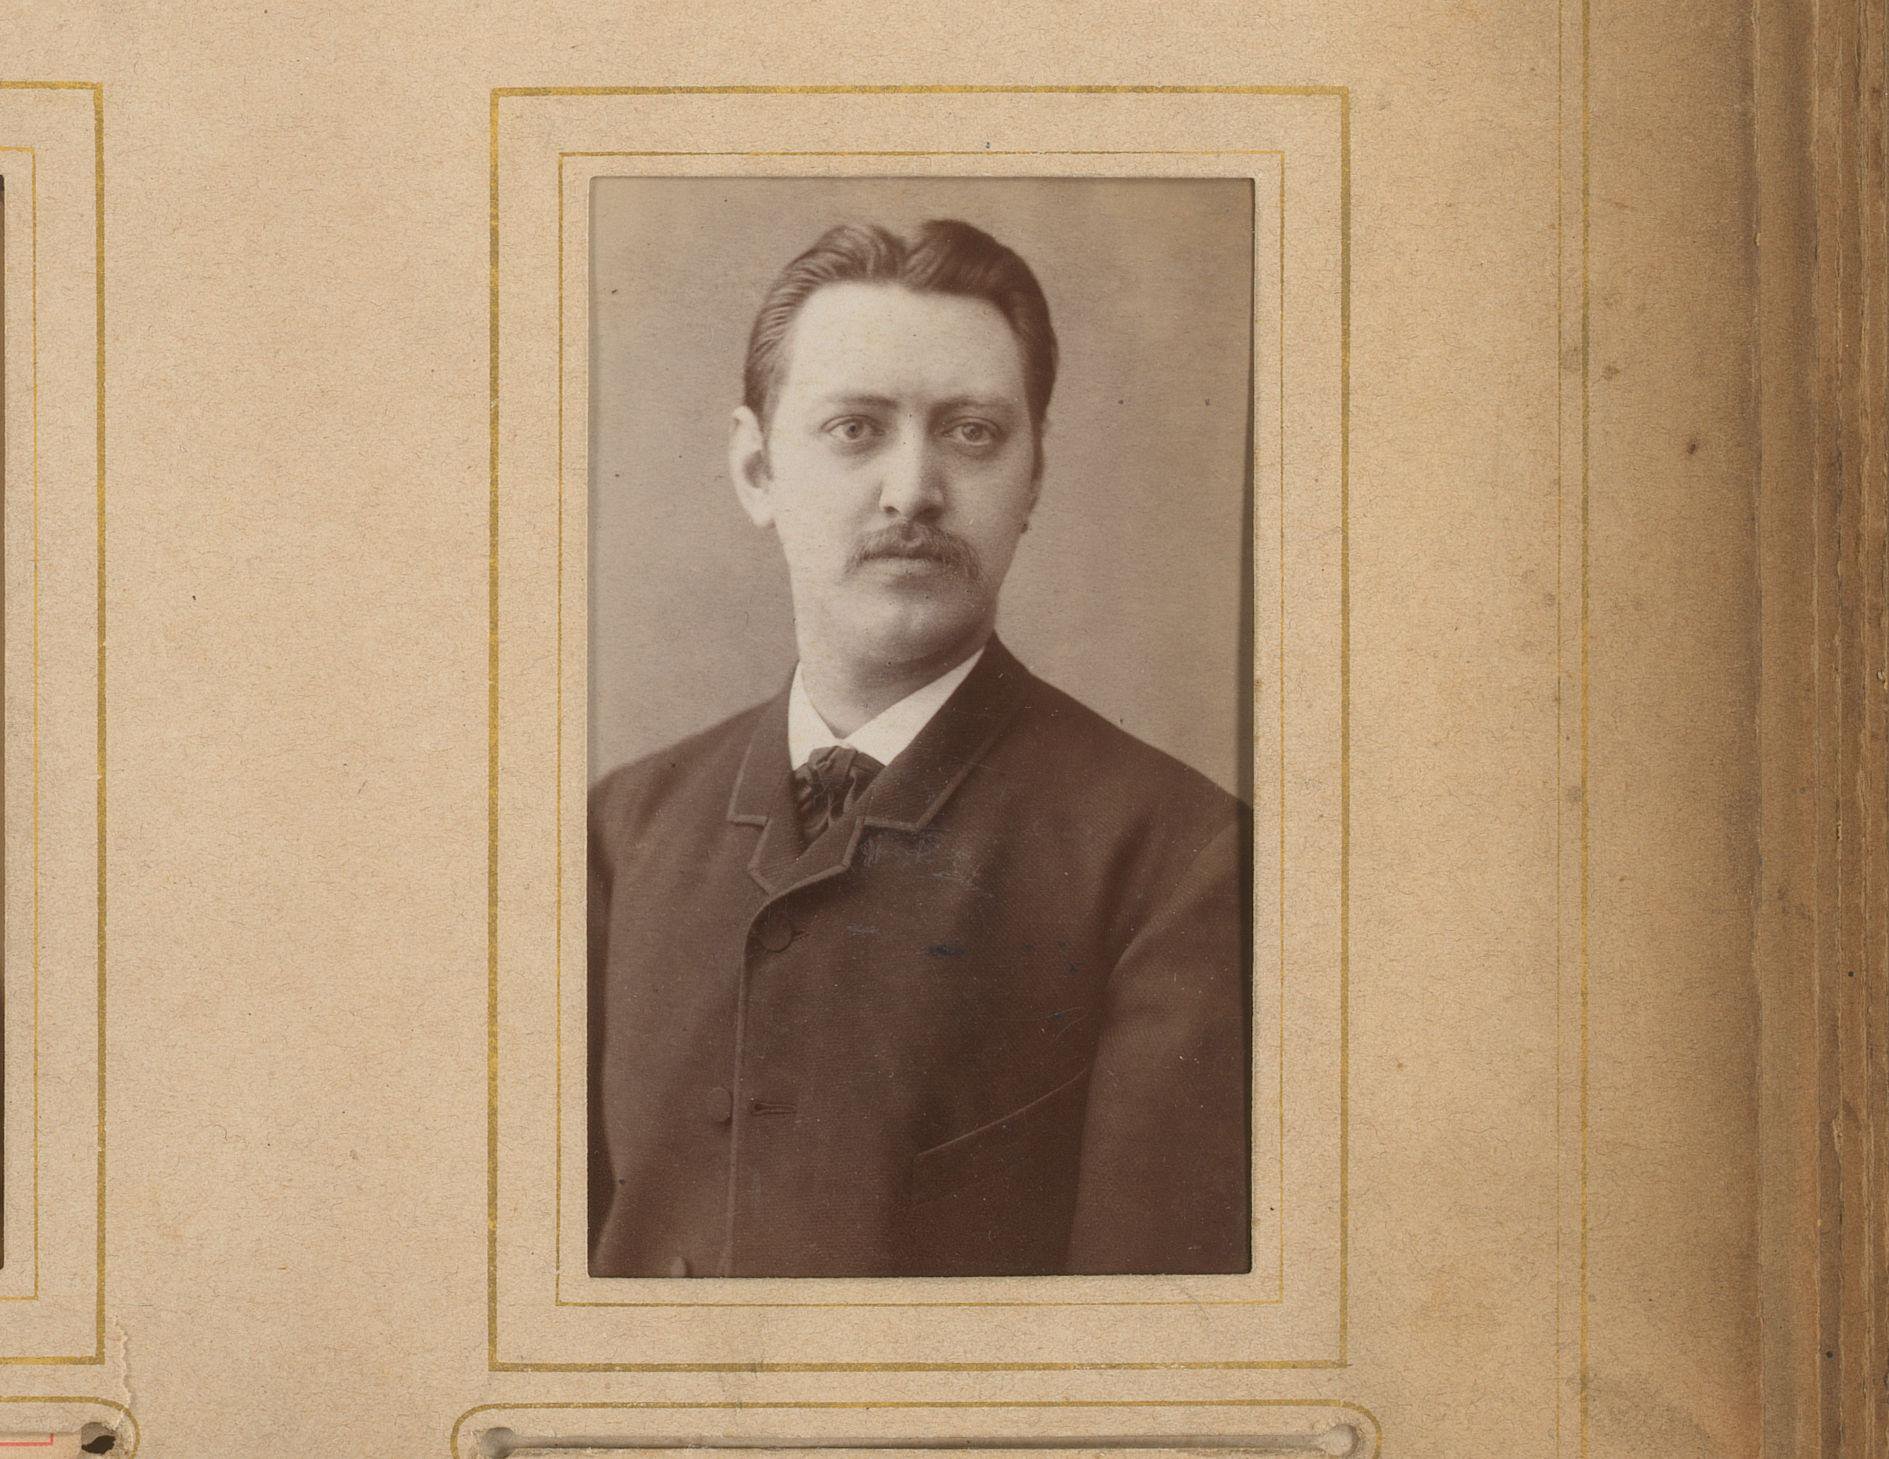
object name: album leaf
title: Portret van een man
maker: Anonymous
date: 1860-1900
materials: cardboard, photographic support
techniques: albumen print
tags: adult man, historical persons